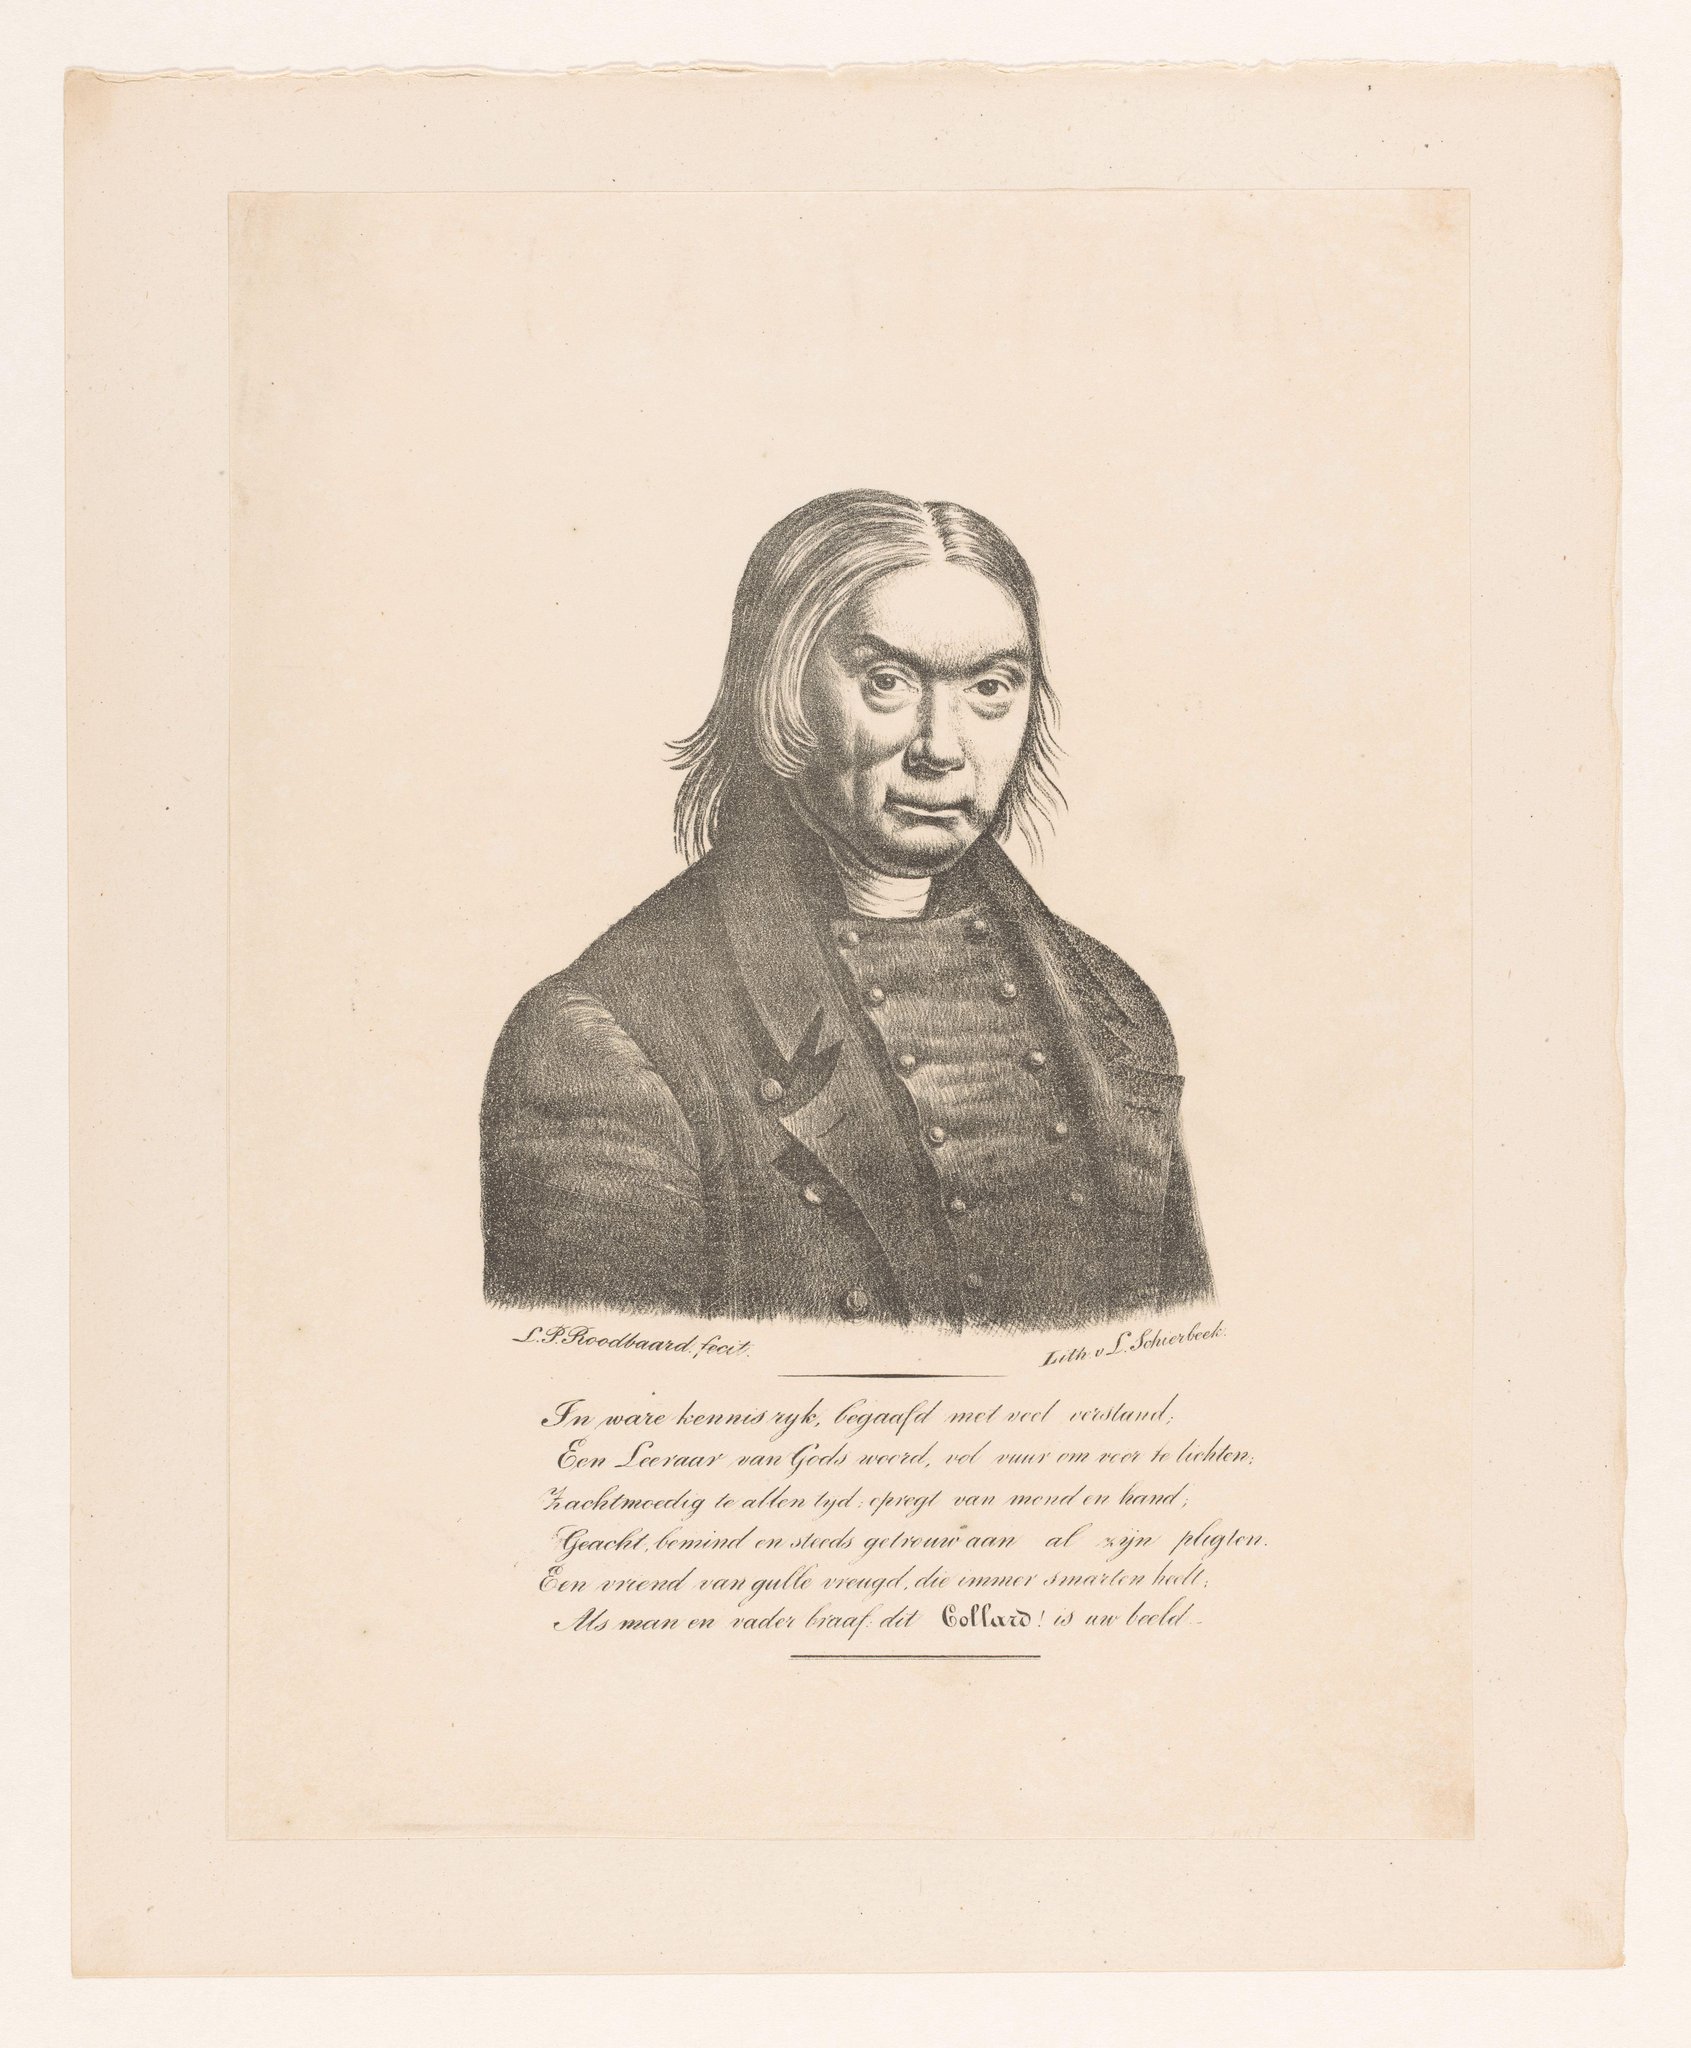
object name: print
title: Portret van Jillis Egedius Collard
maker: lambertus schierbeek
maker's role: printer, publisher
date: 1809-1851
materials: paper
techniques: lithograph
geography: leeuwarden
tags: historical persons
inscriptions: collector's mark: Lugt 2760, collector's mark: Lugt 2166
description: Bij zijn overlijden werd Collard aangeduid als ‘Protestantsch geestelijke in het Huis van Reclusie en Tuchtiging’ en als ‘onderwijzer in de godsdienst’. Dat verklaart ook waarom hij geen befje draagt, zoals predikanten.